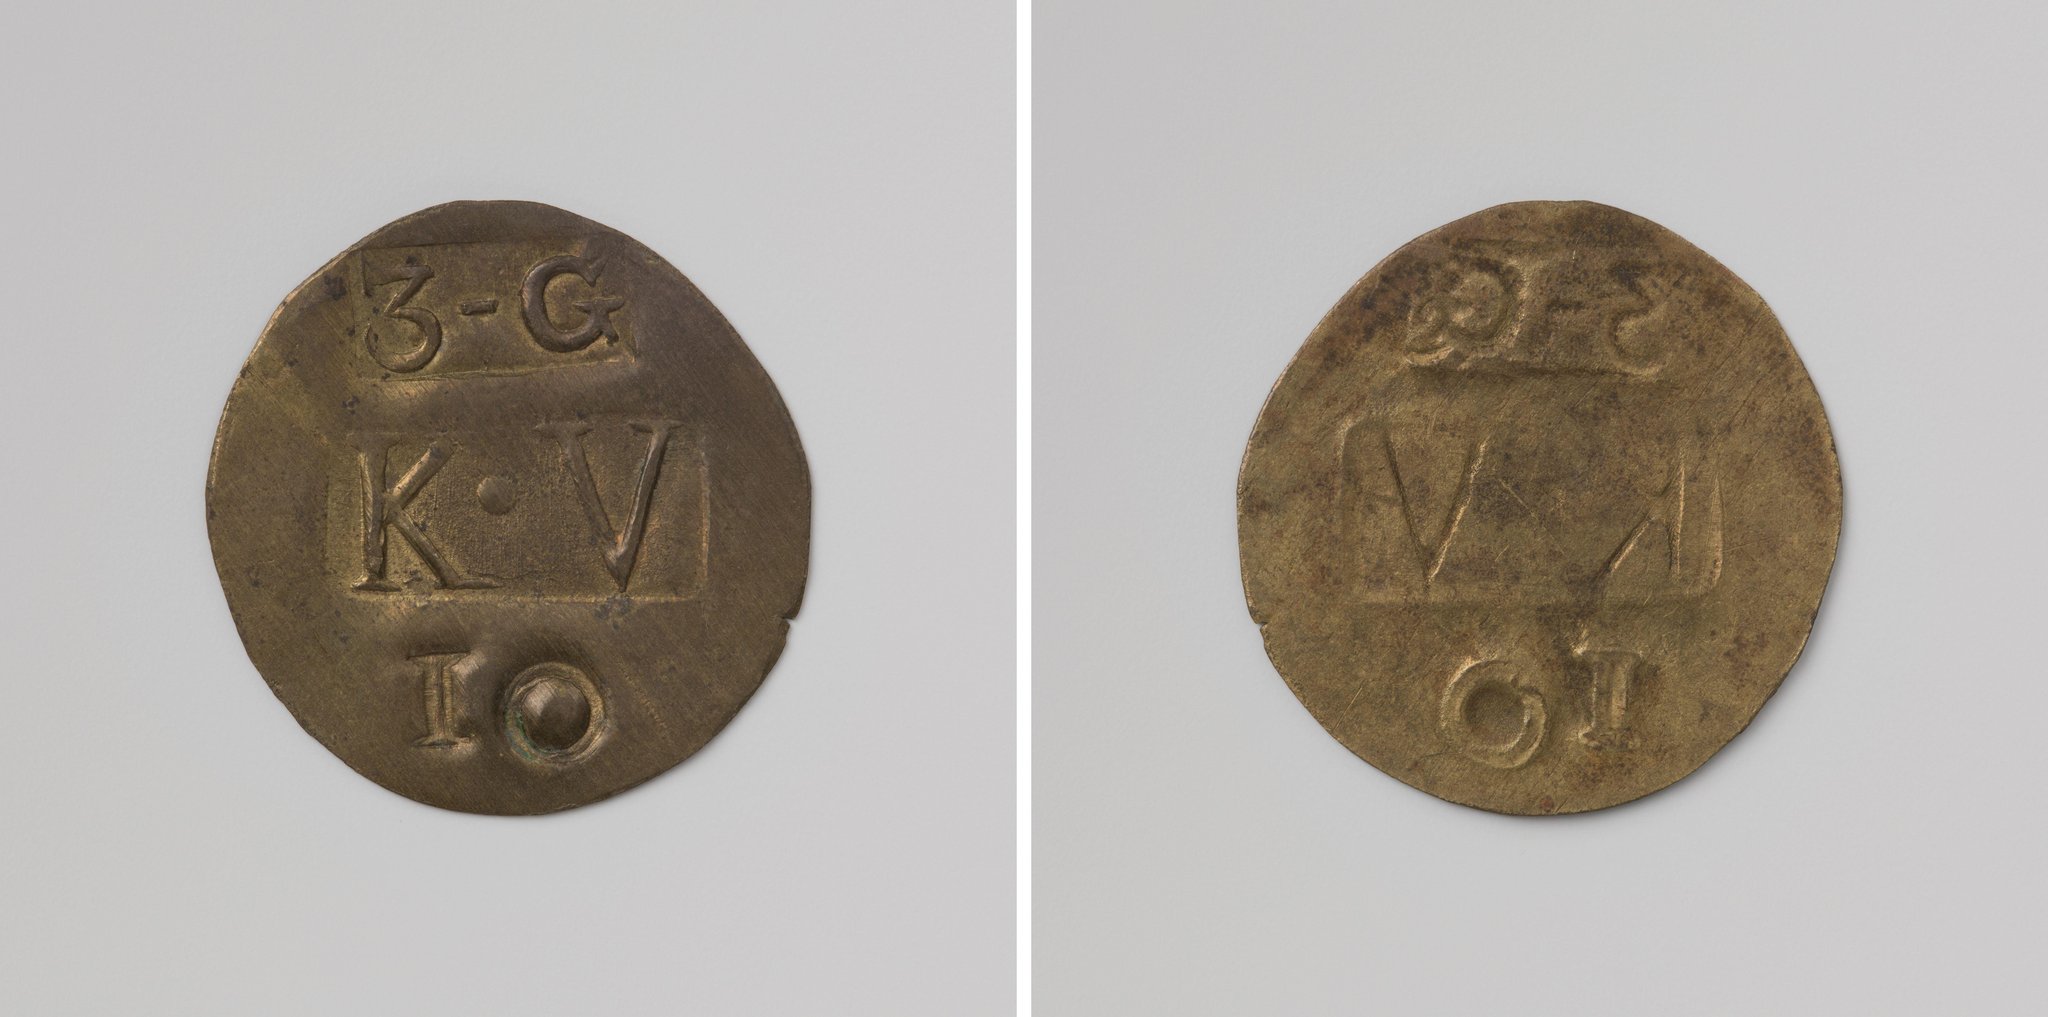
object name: monetary token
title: Derde gesticht van de kolonie Veenhuizen, huismunt geslagen op last van de Maatschappij van Weldadigheid ter waarde van tien cent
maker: Anonymous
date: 1818-1859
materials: brass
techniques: striking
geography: netherlands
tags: maatschappij van weldadigheid, veenhuizen